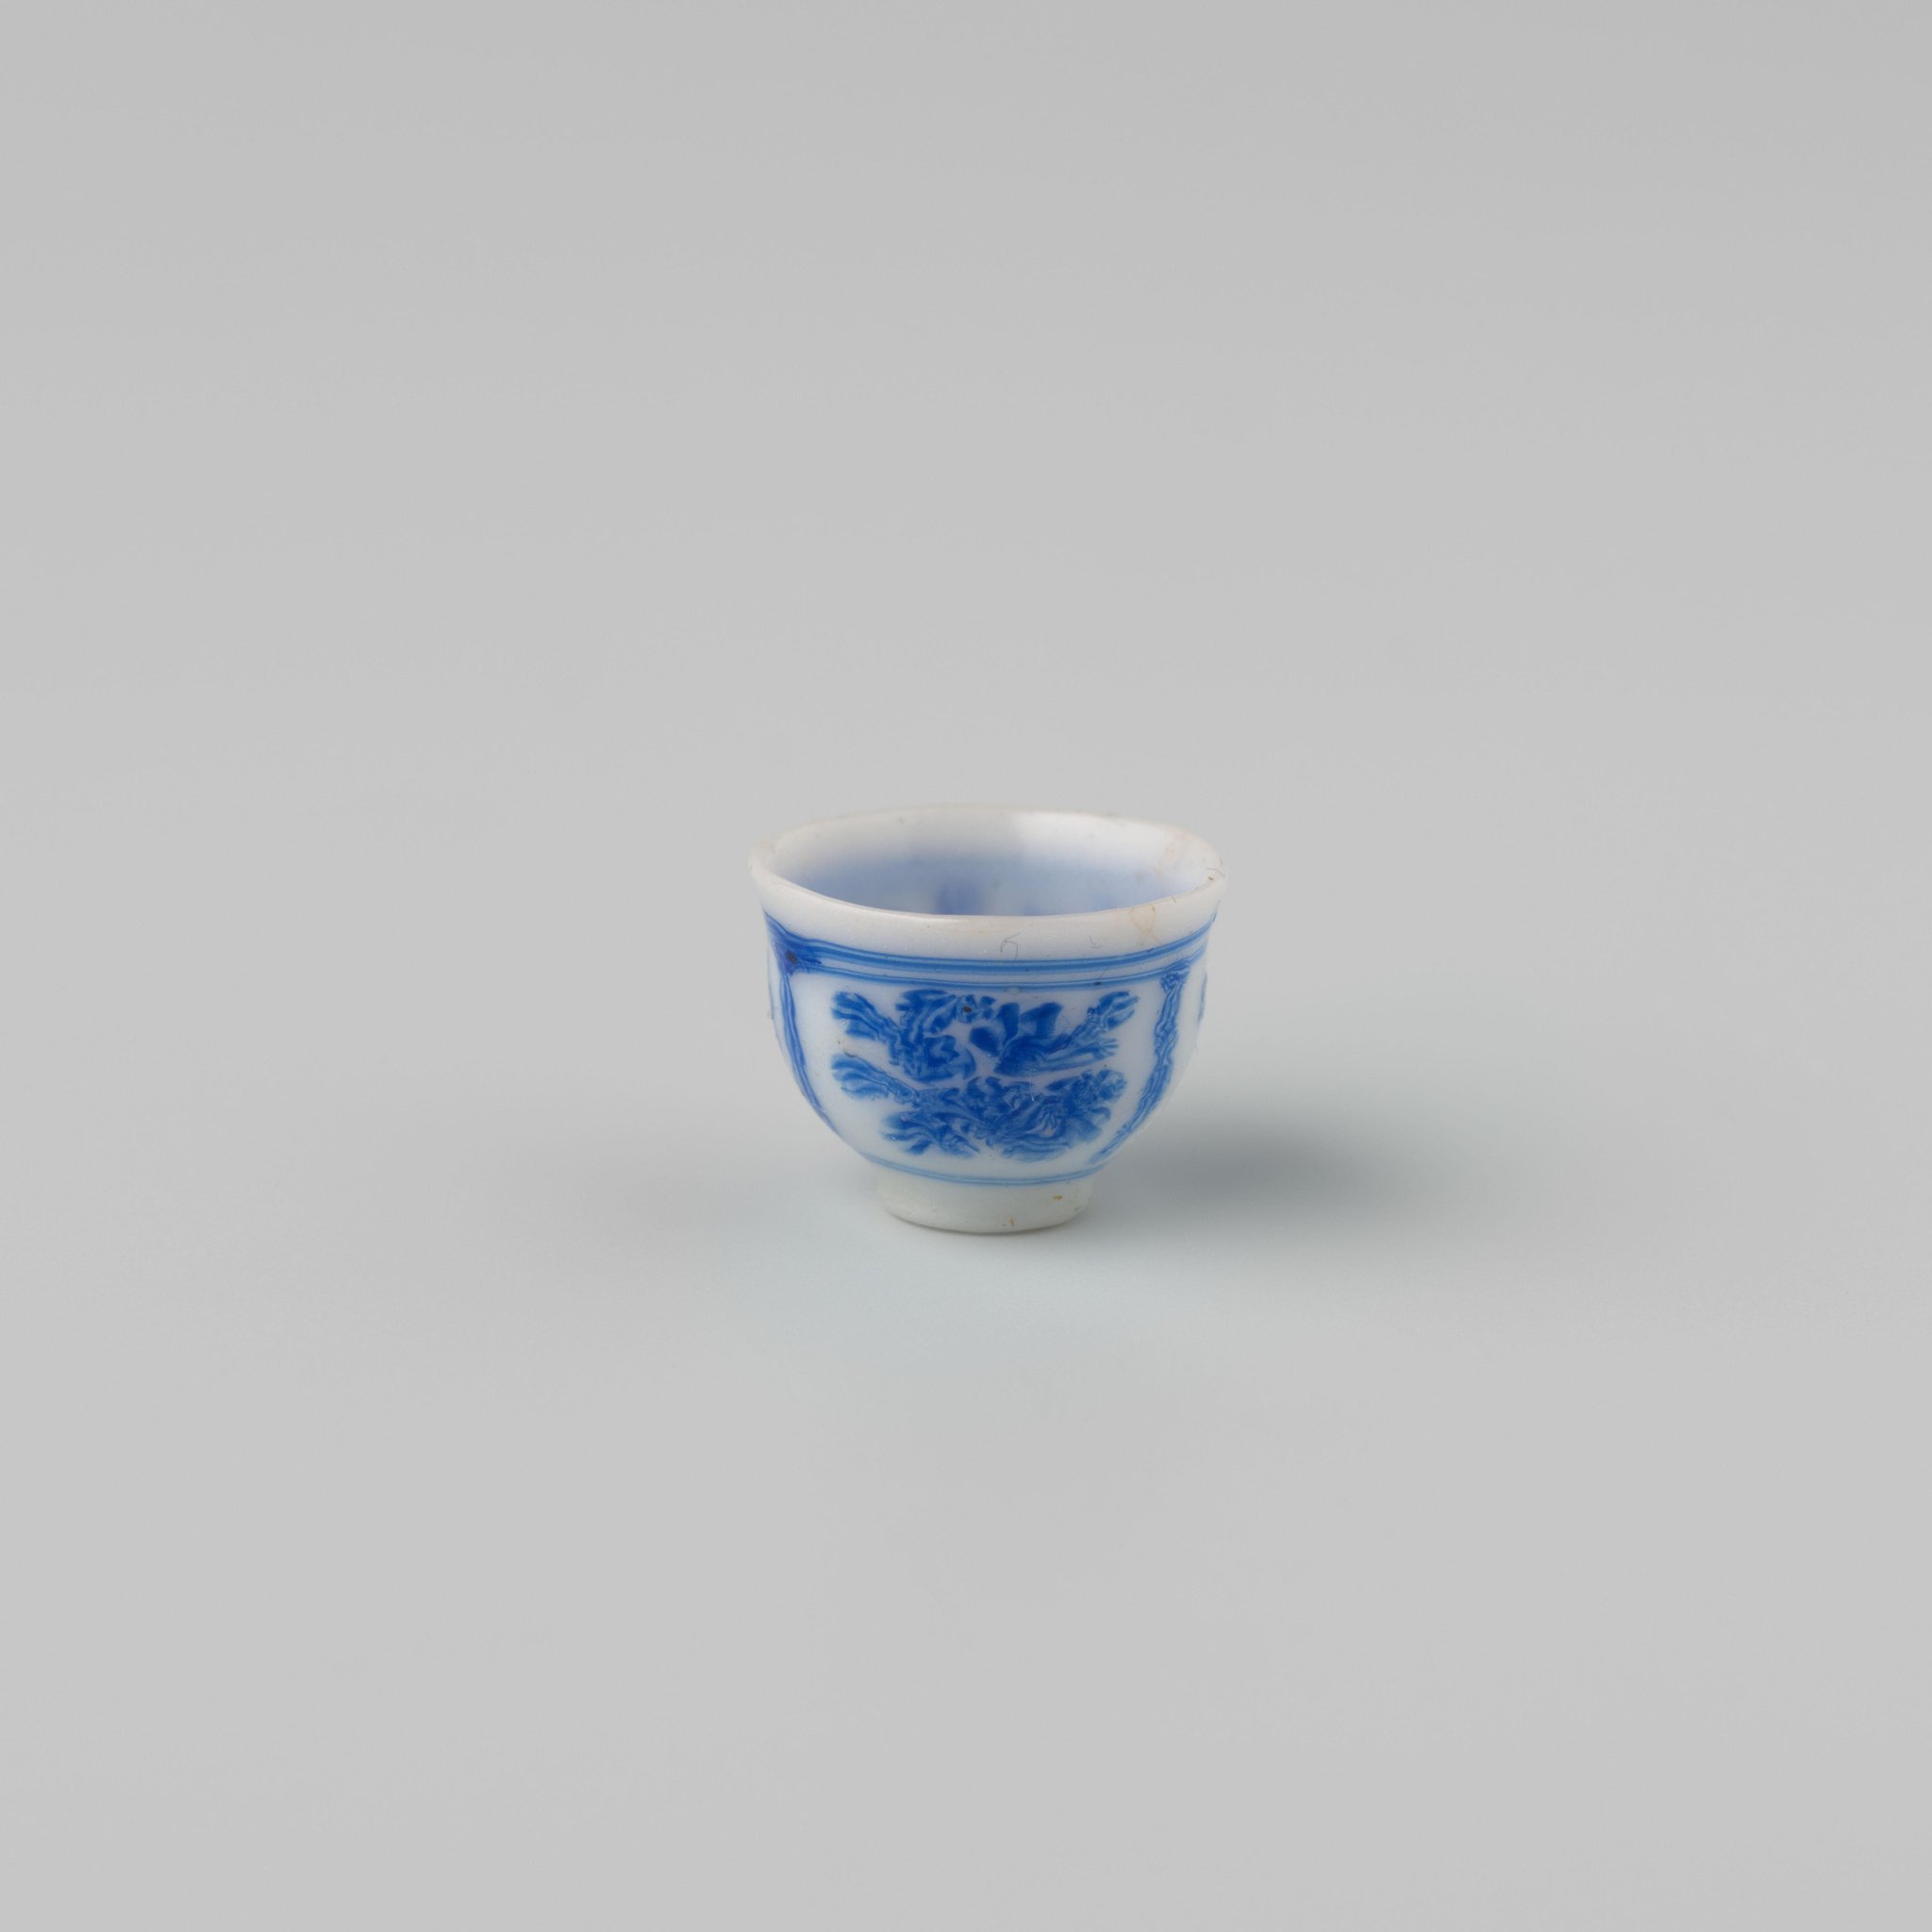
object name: tea cup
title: Theekopje van melkglas met blauwe emailverf beschildering, imitatie Chinees porselein met 'bloem' decoratie in vakken; op standring en met gladde mondrand.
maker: Anonymous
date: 1675-1710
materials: glass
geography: amsterdam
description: Kopje van melkglas met emailverf beschildering, imitatie Chinees blauw porselein met bloem versiering in vakken; op standring en met gladde mondrand.